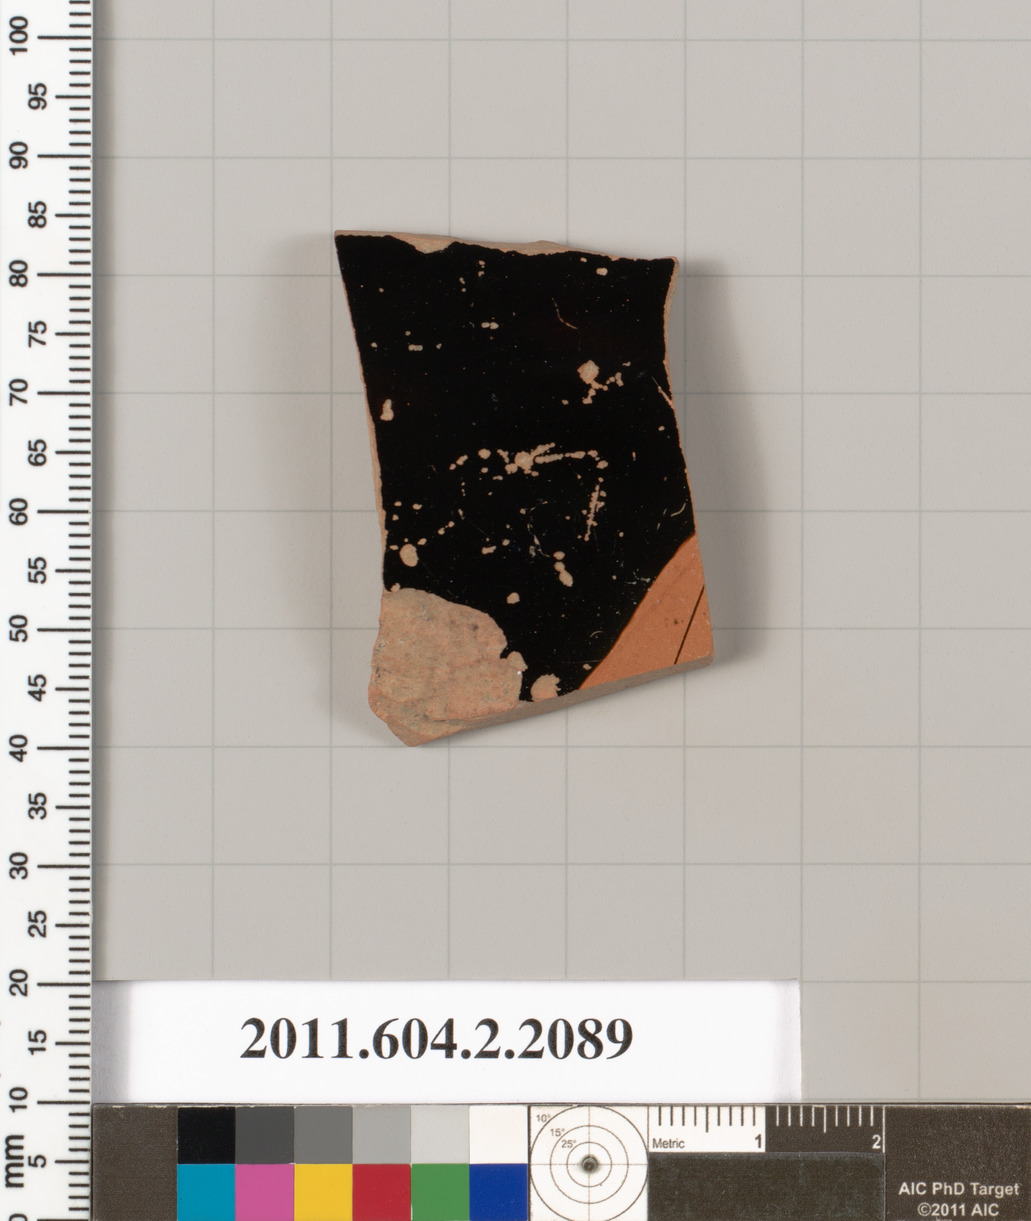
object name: pot fragment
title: Terracotta fragment of a pot; glazed on the inside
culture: greek, attic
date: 475-451 BCE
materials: terracotta